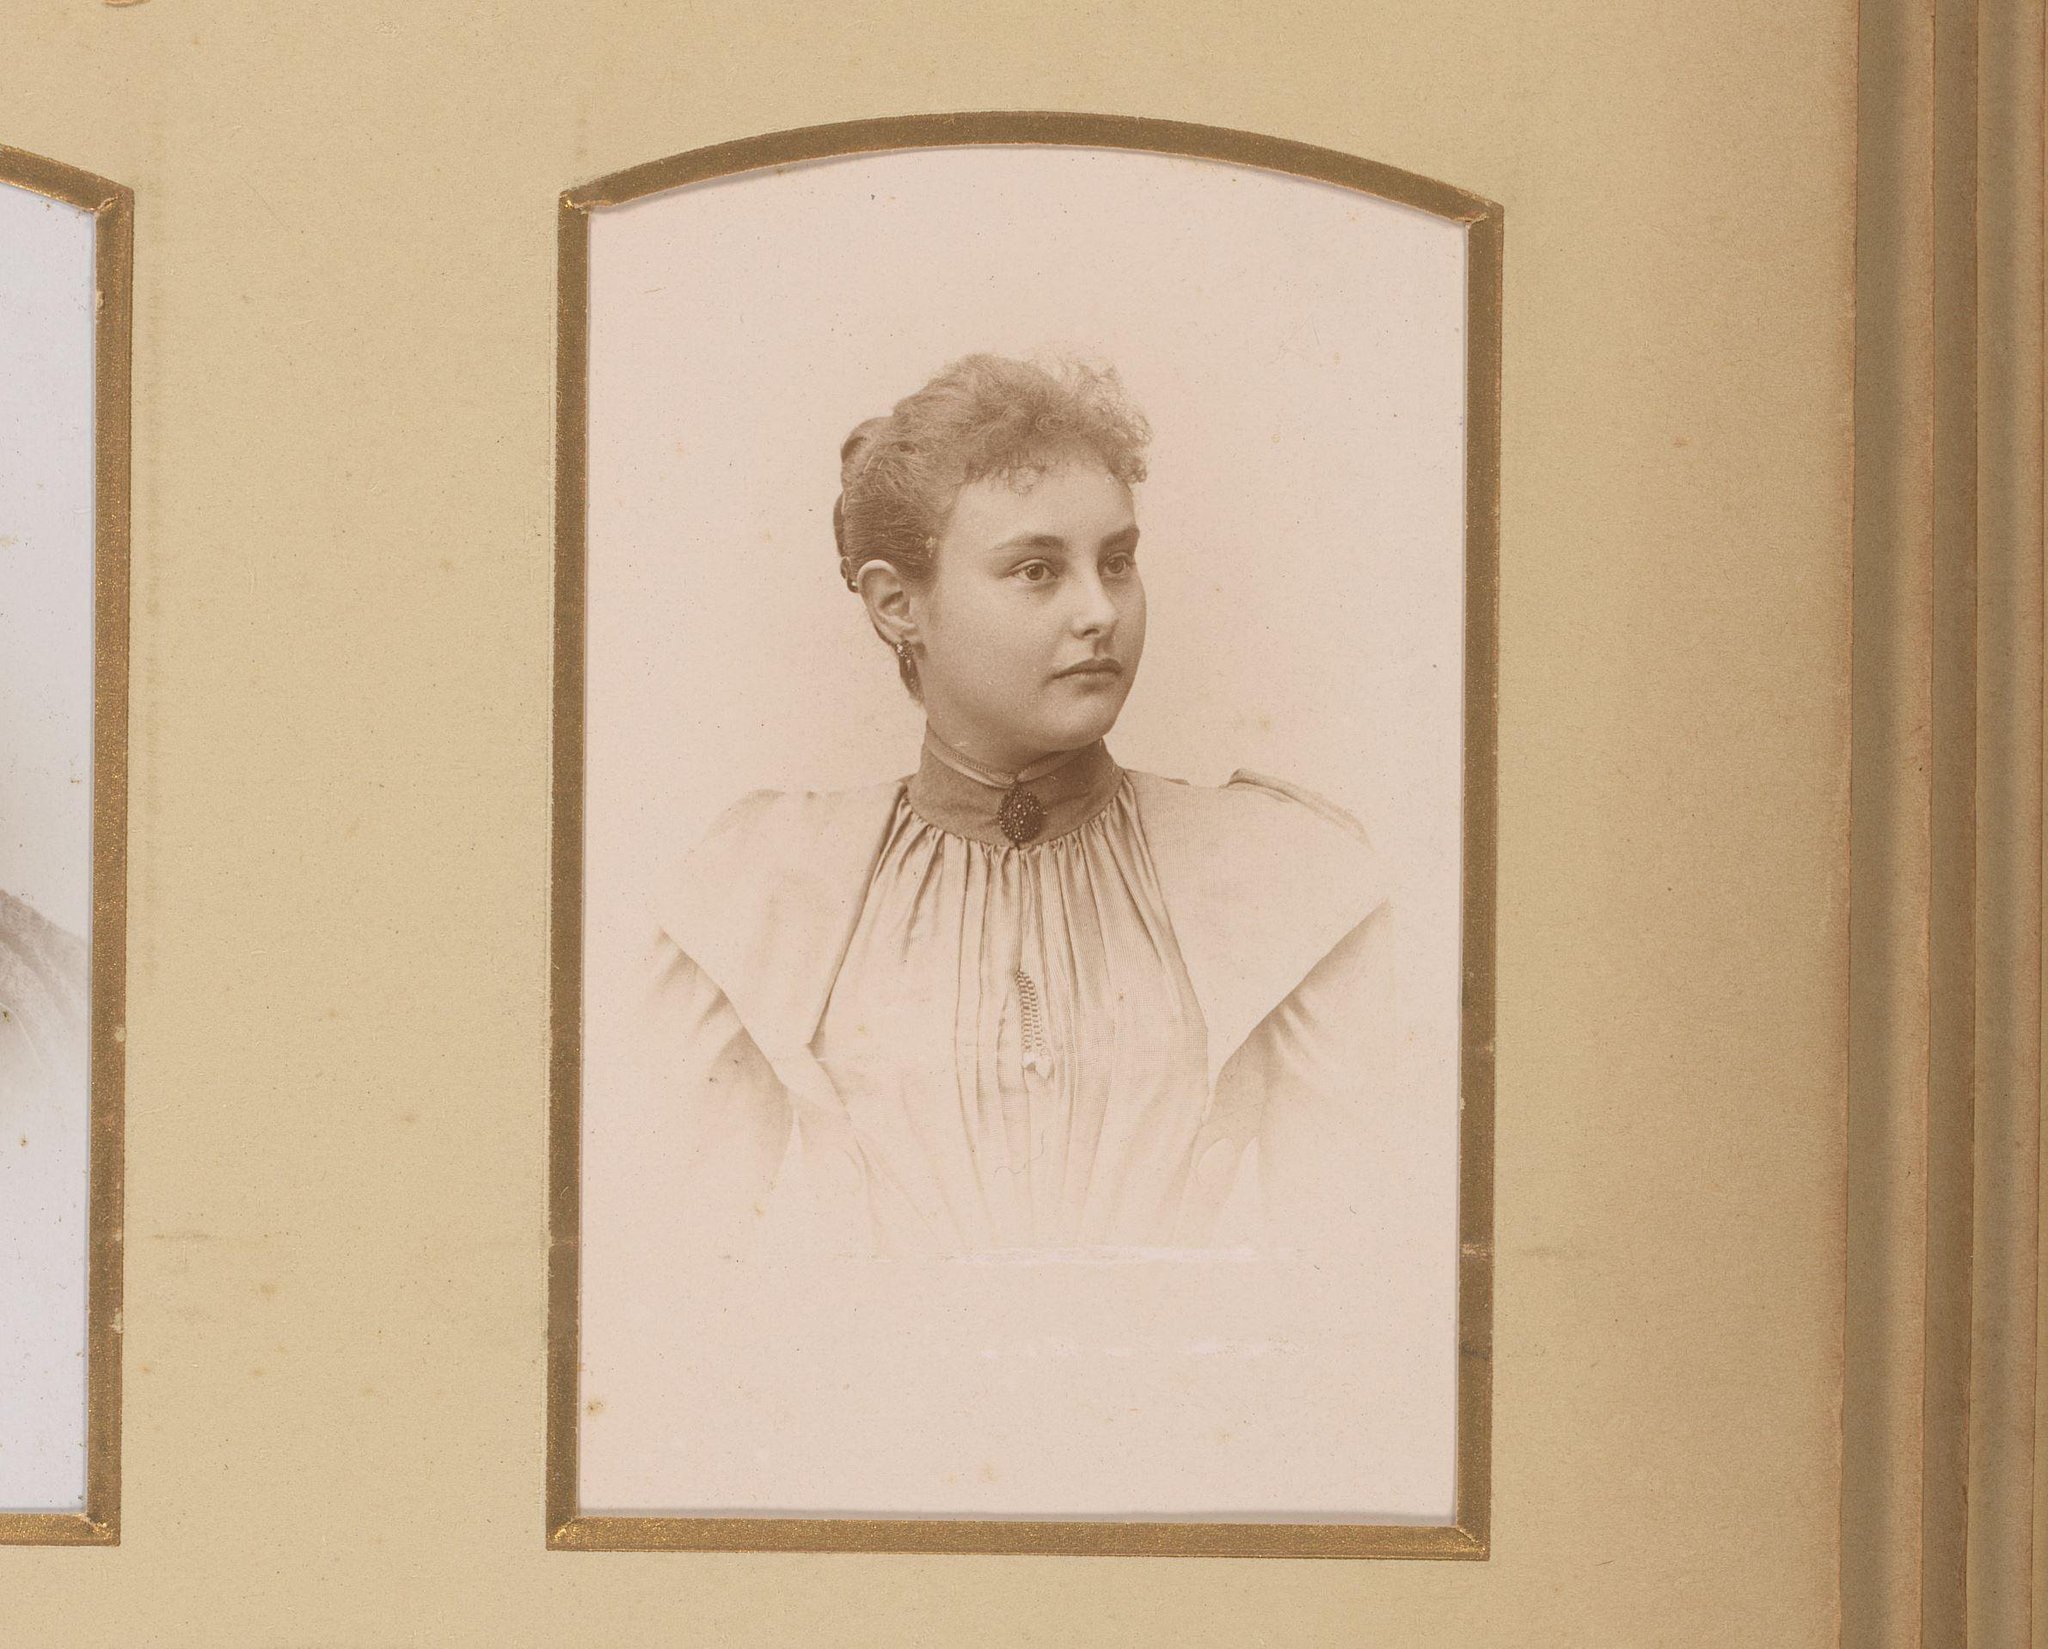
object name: album leaf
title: Portret van een jonge vrouw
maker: johannes leonardus van der heijden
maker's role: fotograaf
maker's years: 1856-1937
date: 1893-1915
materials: cardboard, photographic support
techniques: collodion silver print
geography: amsterdam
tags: adolescent, young woman, maiden, historical persons - bb - woman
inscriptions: inscription: ‘Eere Diploma/ UTRECHT 1893./ (...)/ Johs L. van der Heijden/ Amsterdam/ Sophiaplein MUNT./ Specialiteit in onveranderlijke/ photographien en vergrootingen.’